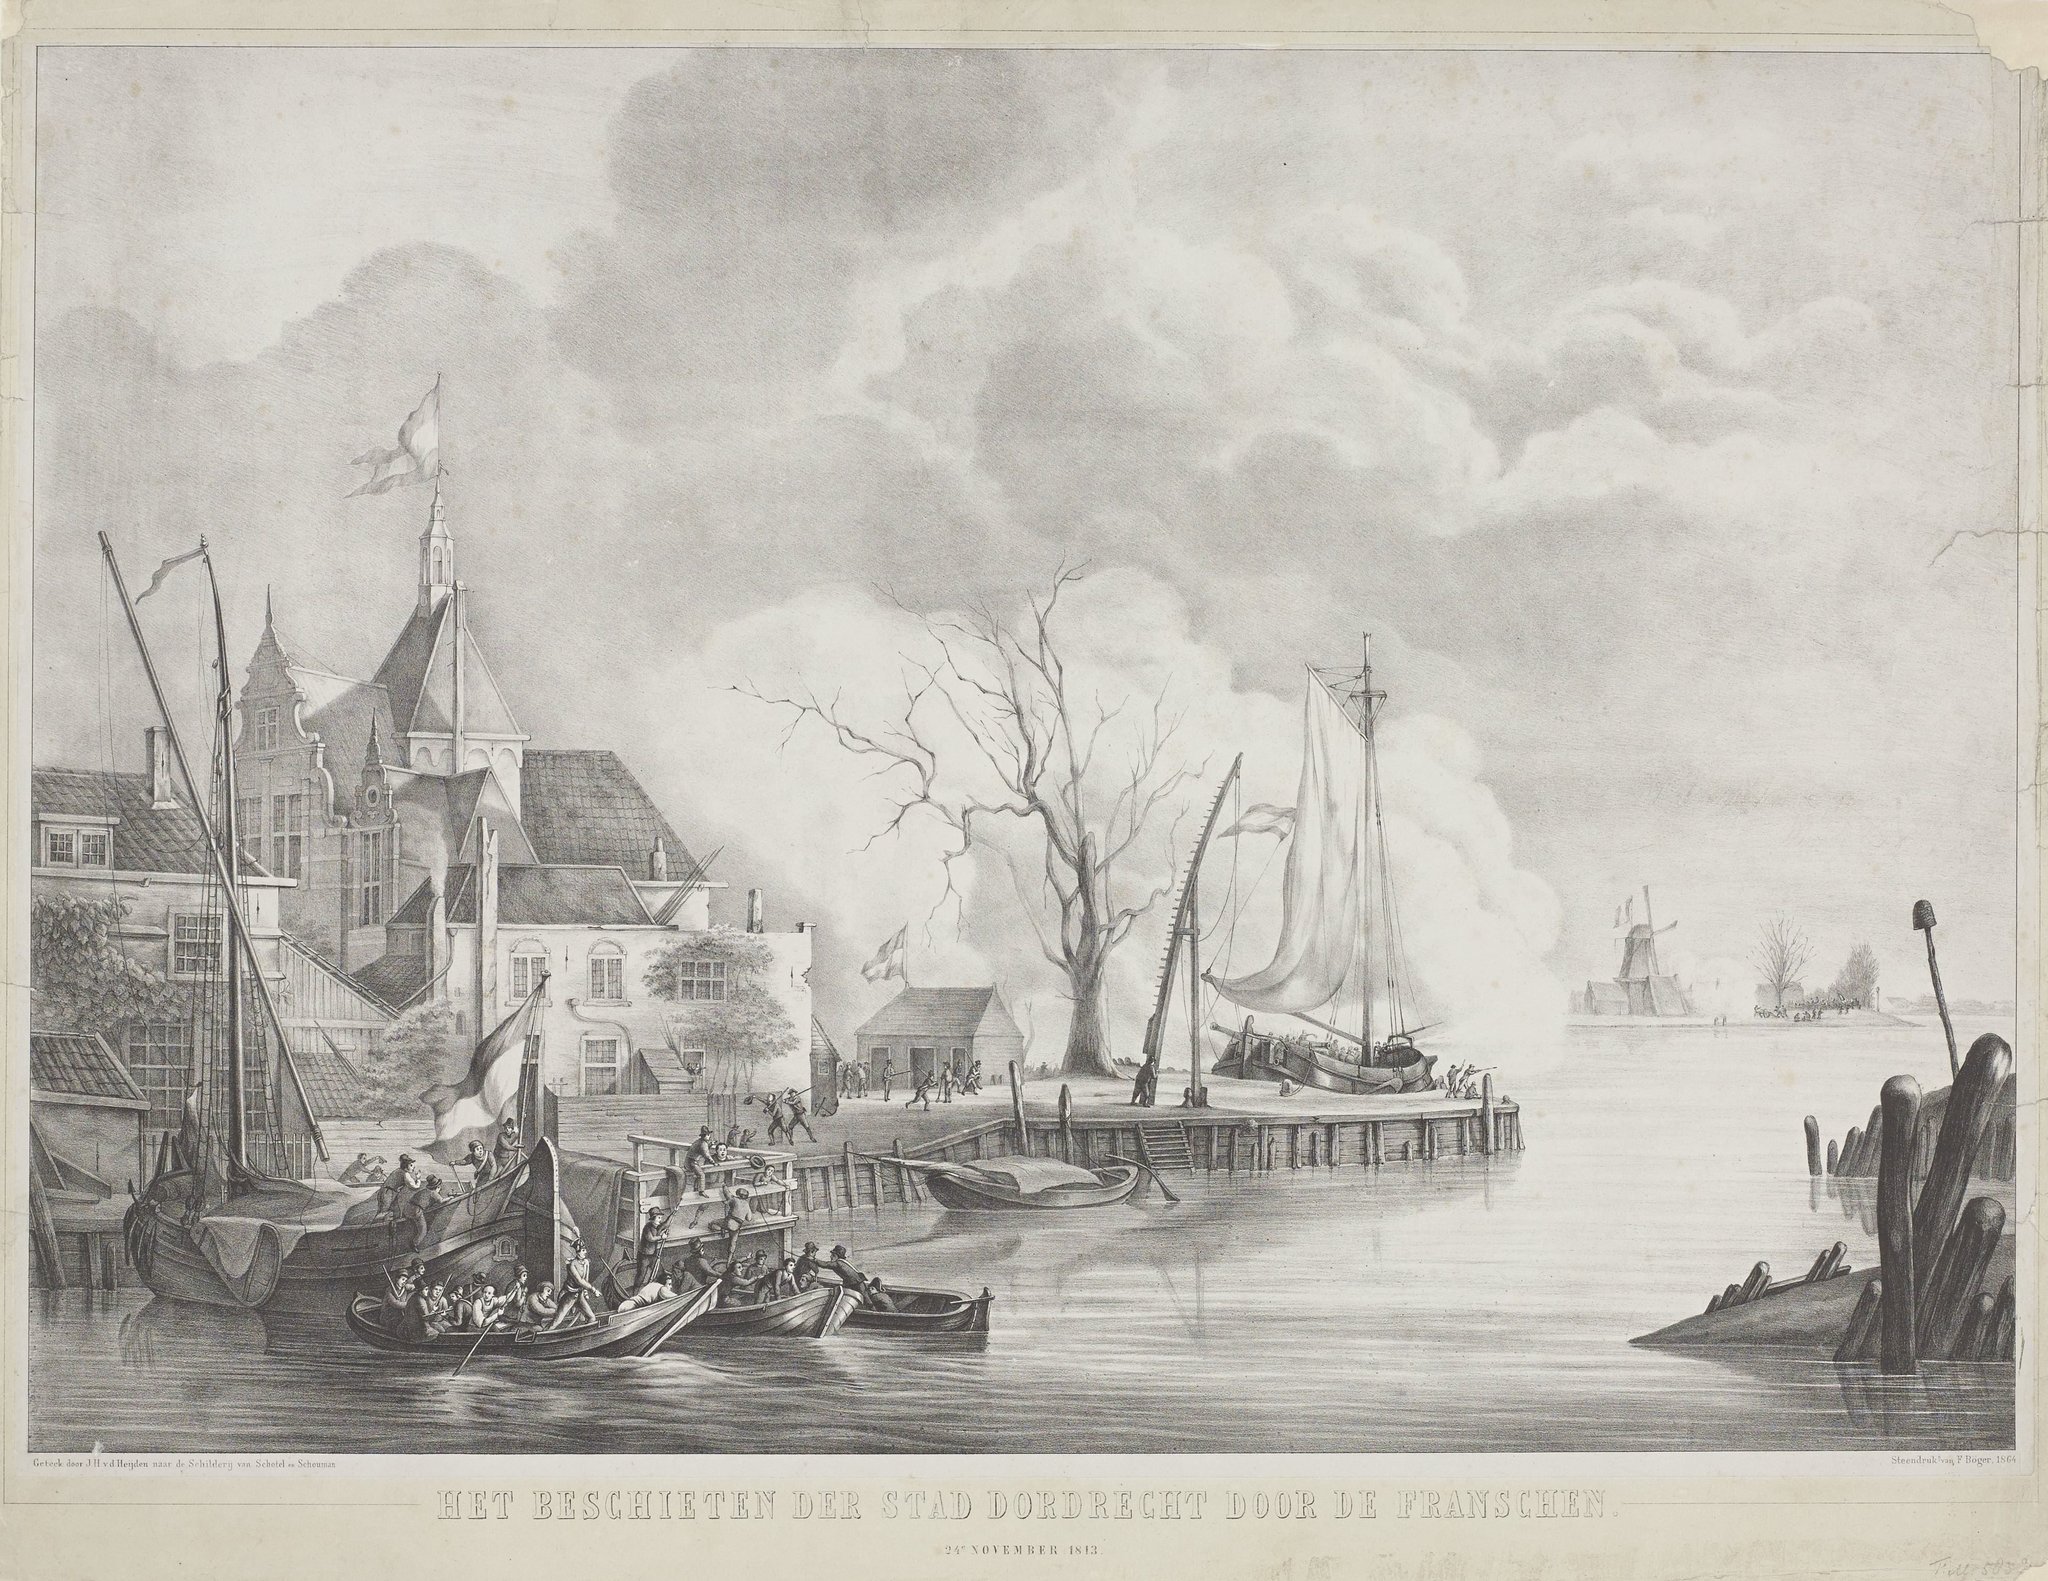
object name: print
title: Het beschieten der stad Dordrecht door de Franschen. 24e November 1813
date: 1864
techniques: printmaking, lithograph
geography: netherlands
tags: small groups in single combat in place of battle, dordrecht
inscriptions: collector's mark: Lugt 2228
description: Beschieting door een Franse batterij van de Rietdijkse Poort en Hoofd te Dordrecht op 24 november 1813. Op de voorgrond een haven met verschillende boten, een Nederlandse kanonneerboot beantwoordt het vuur.